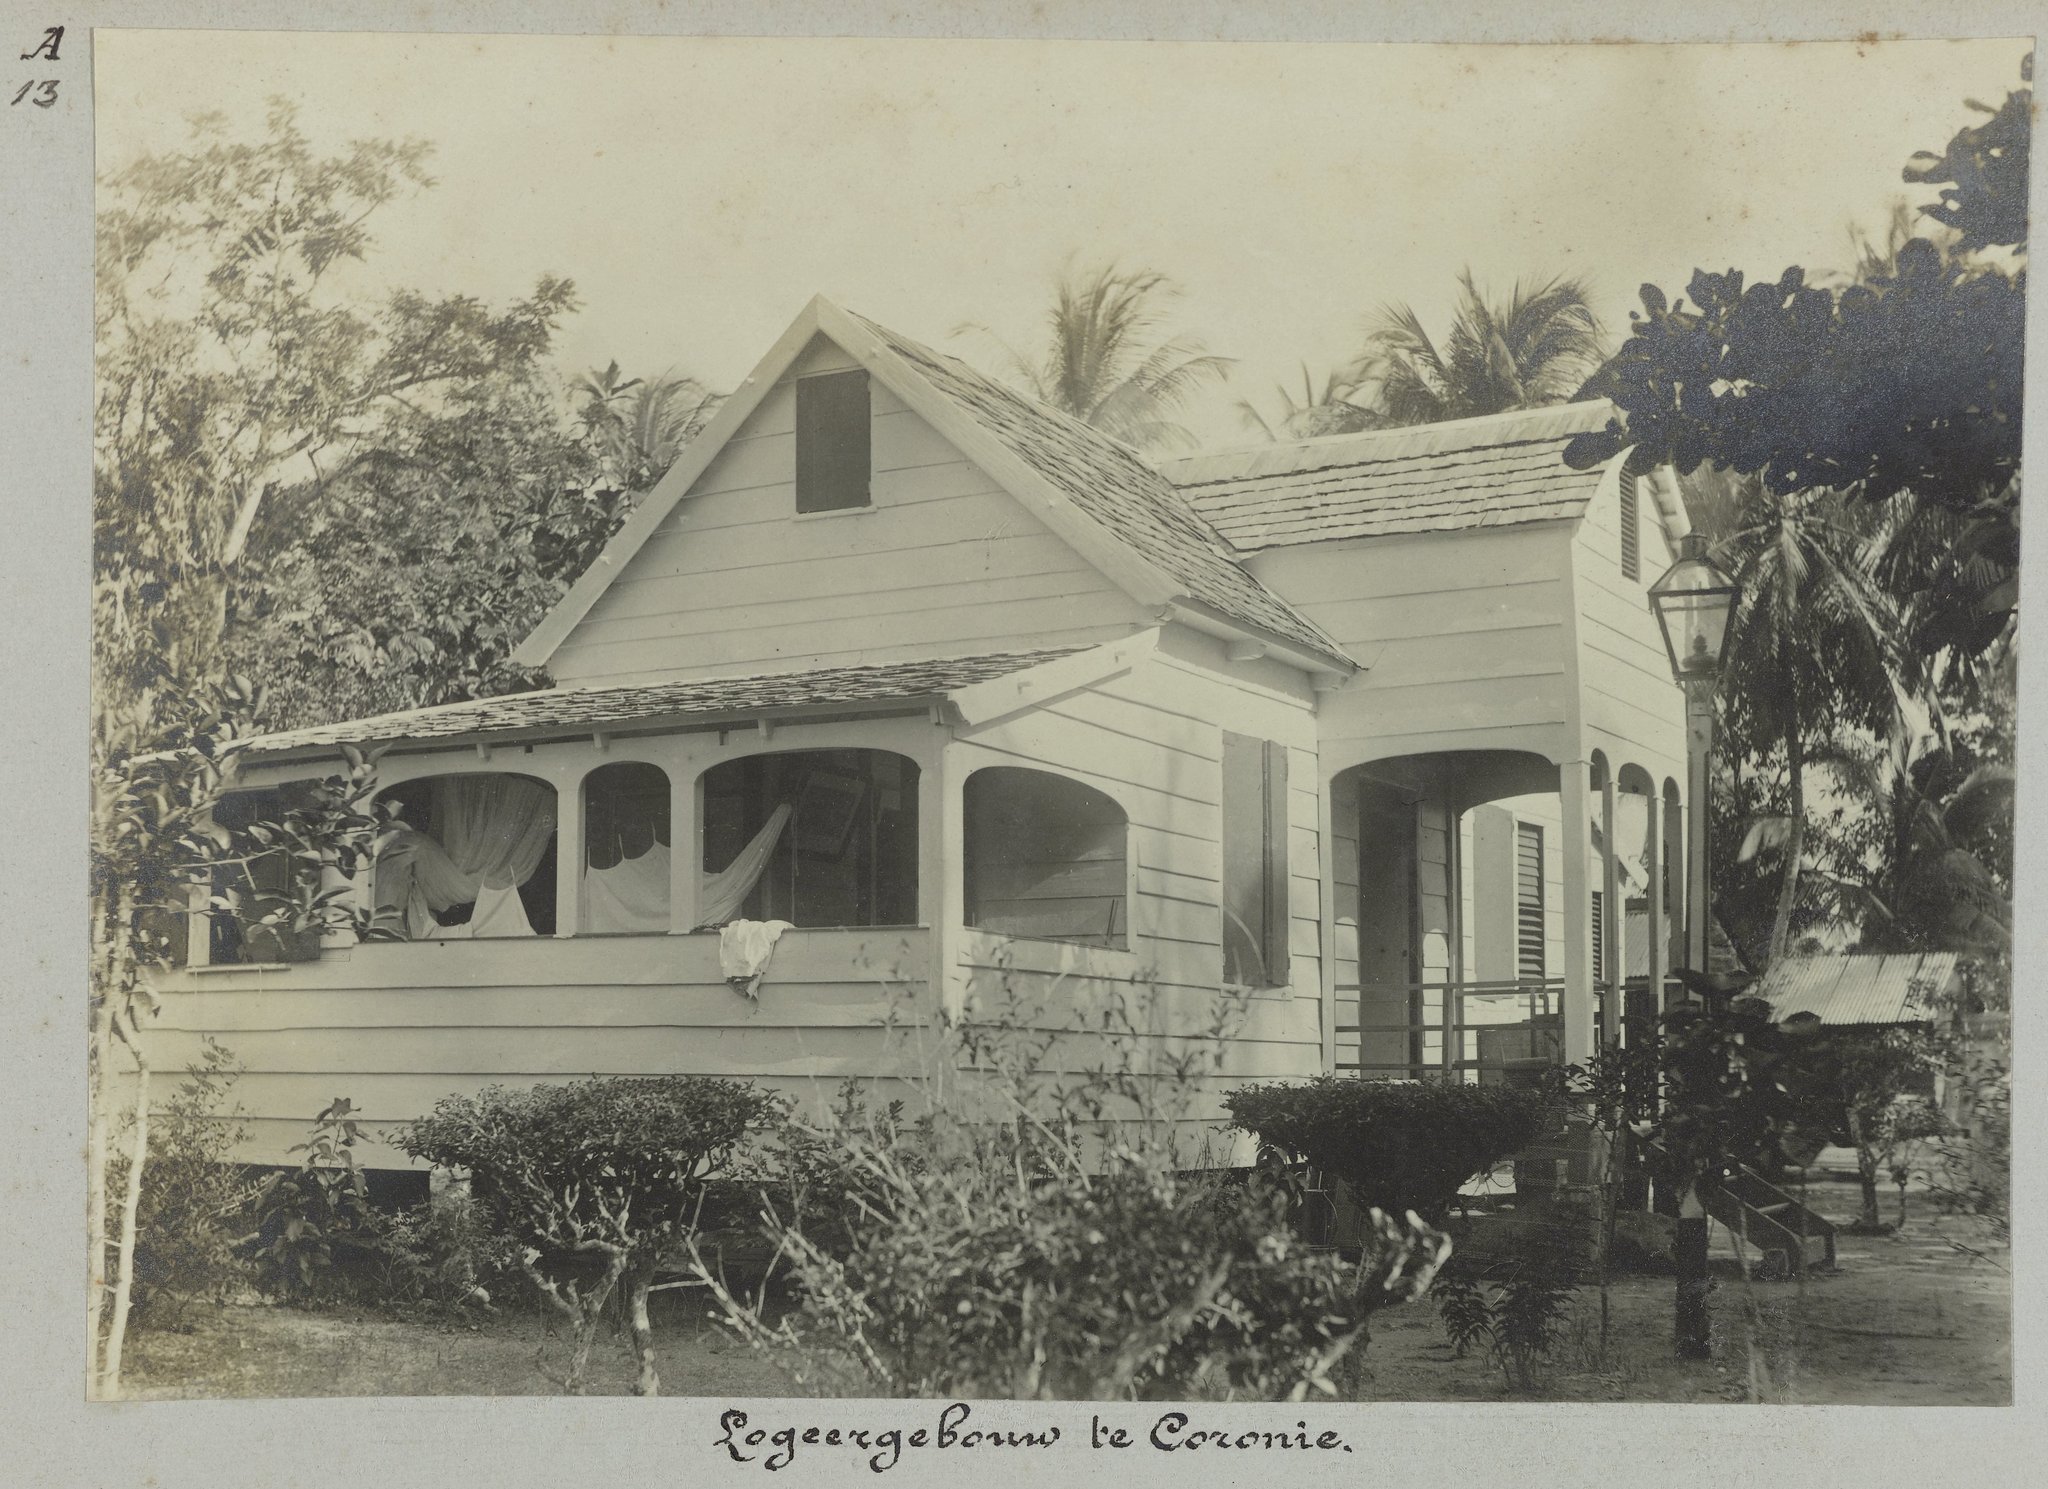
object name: photograph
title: Logeergebouw te Coronie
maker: hendrik doijer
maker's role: engineer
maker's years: 1863-1925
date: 1903-1910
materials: photographic support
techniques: gelatin silver print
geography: suriname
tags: suriname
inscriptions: inscription: ‘A13 / Logeergebouw te Coronie.’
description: Een logeergebouw, hotel of herberg, te Coronie. Onderdeel van het fotoalbum Souvenir de Voyage (deel 1), over het leven van de familie Doijer in en rond de plantage Ma Retraite in Suriname in de jaren 1903-1910.